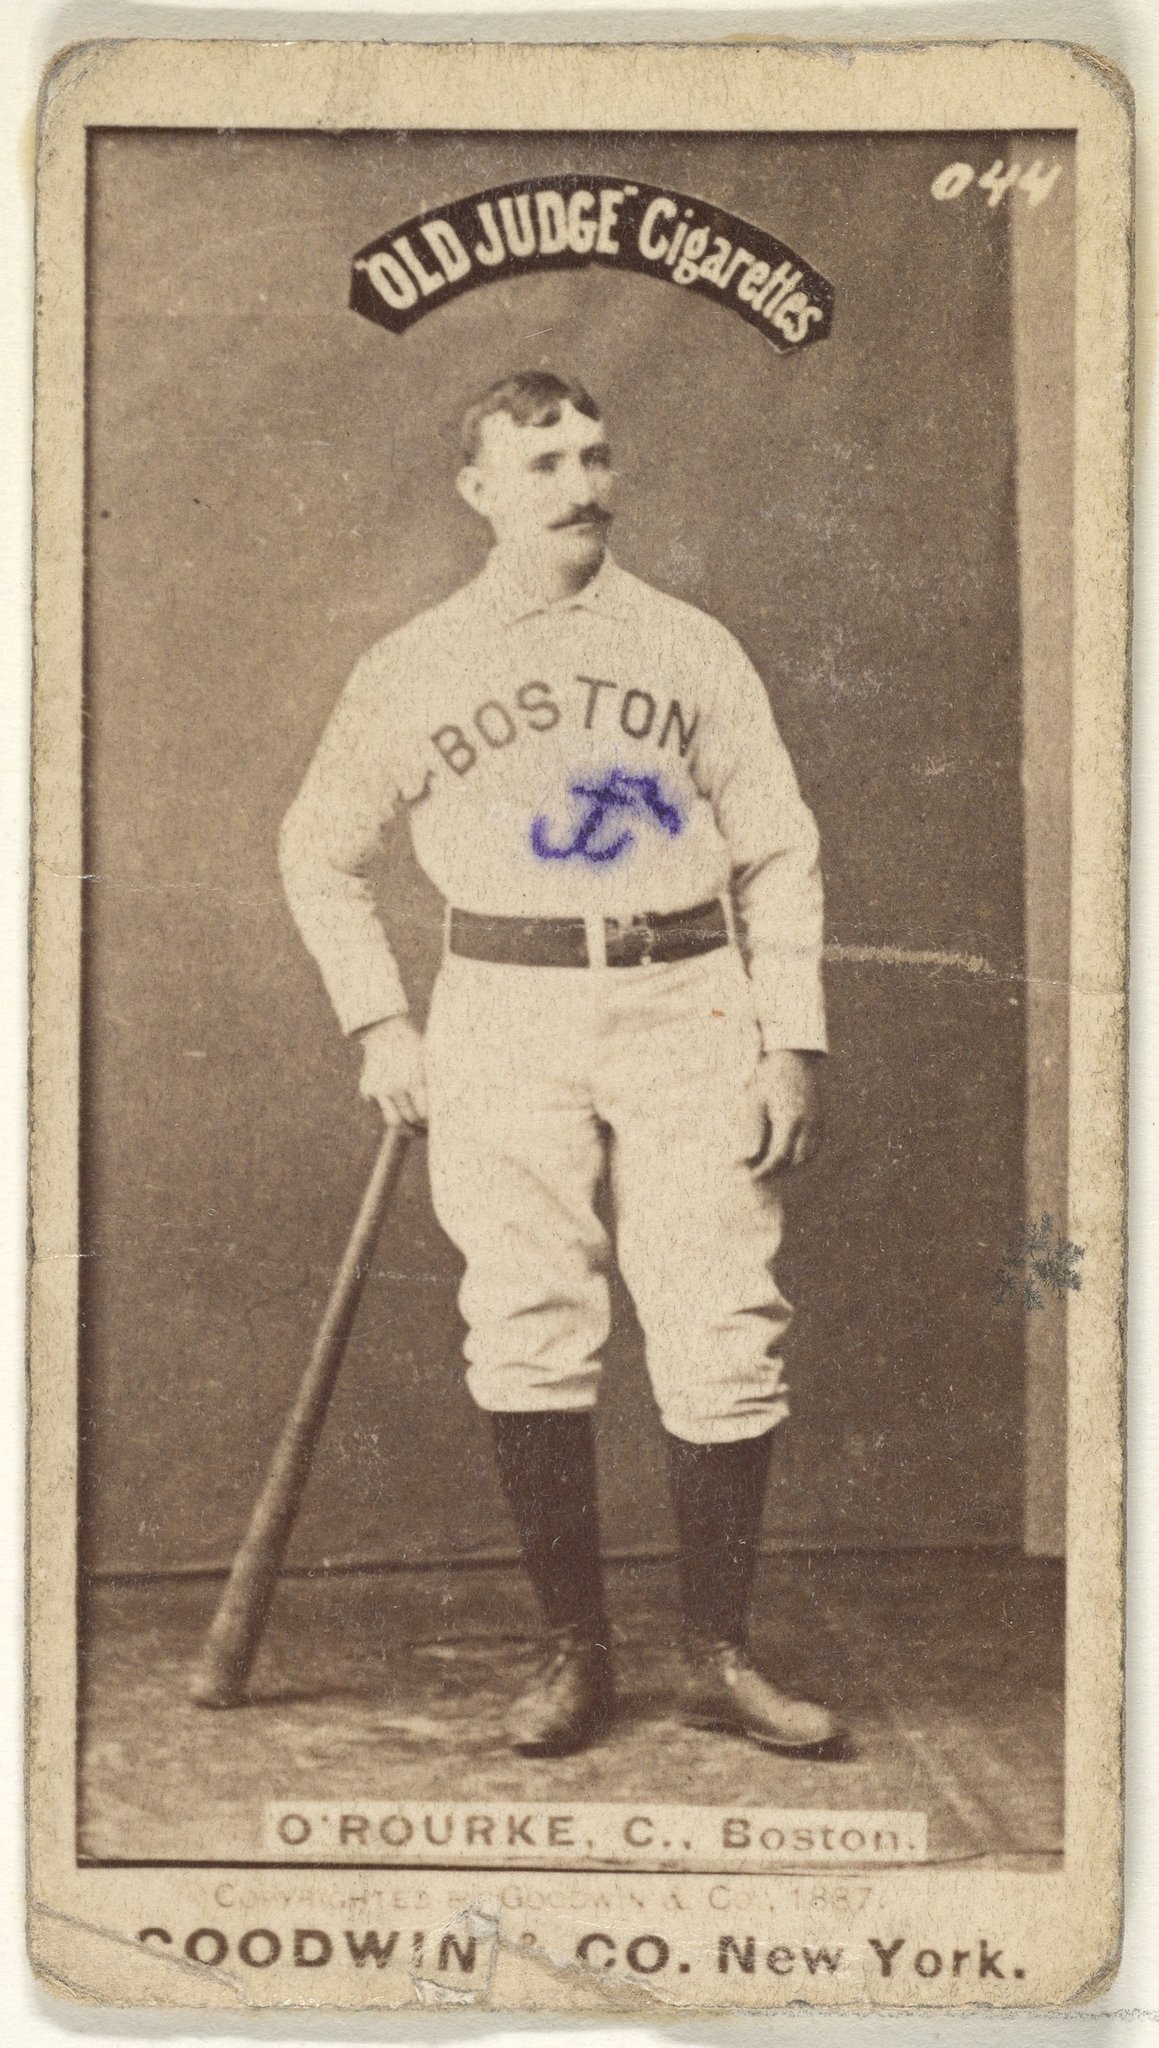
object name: baseball card, photograph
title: O'Rourke, Catcher, Boston, from the Old Judge series (N172) for Old Judge Cigarettes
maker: goodwin & company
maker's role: publisher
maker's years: 1850-1950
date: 1887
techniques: albumen silver print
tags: men,portraits,baseball,athletes